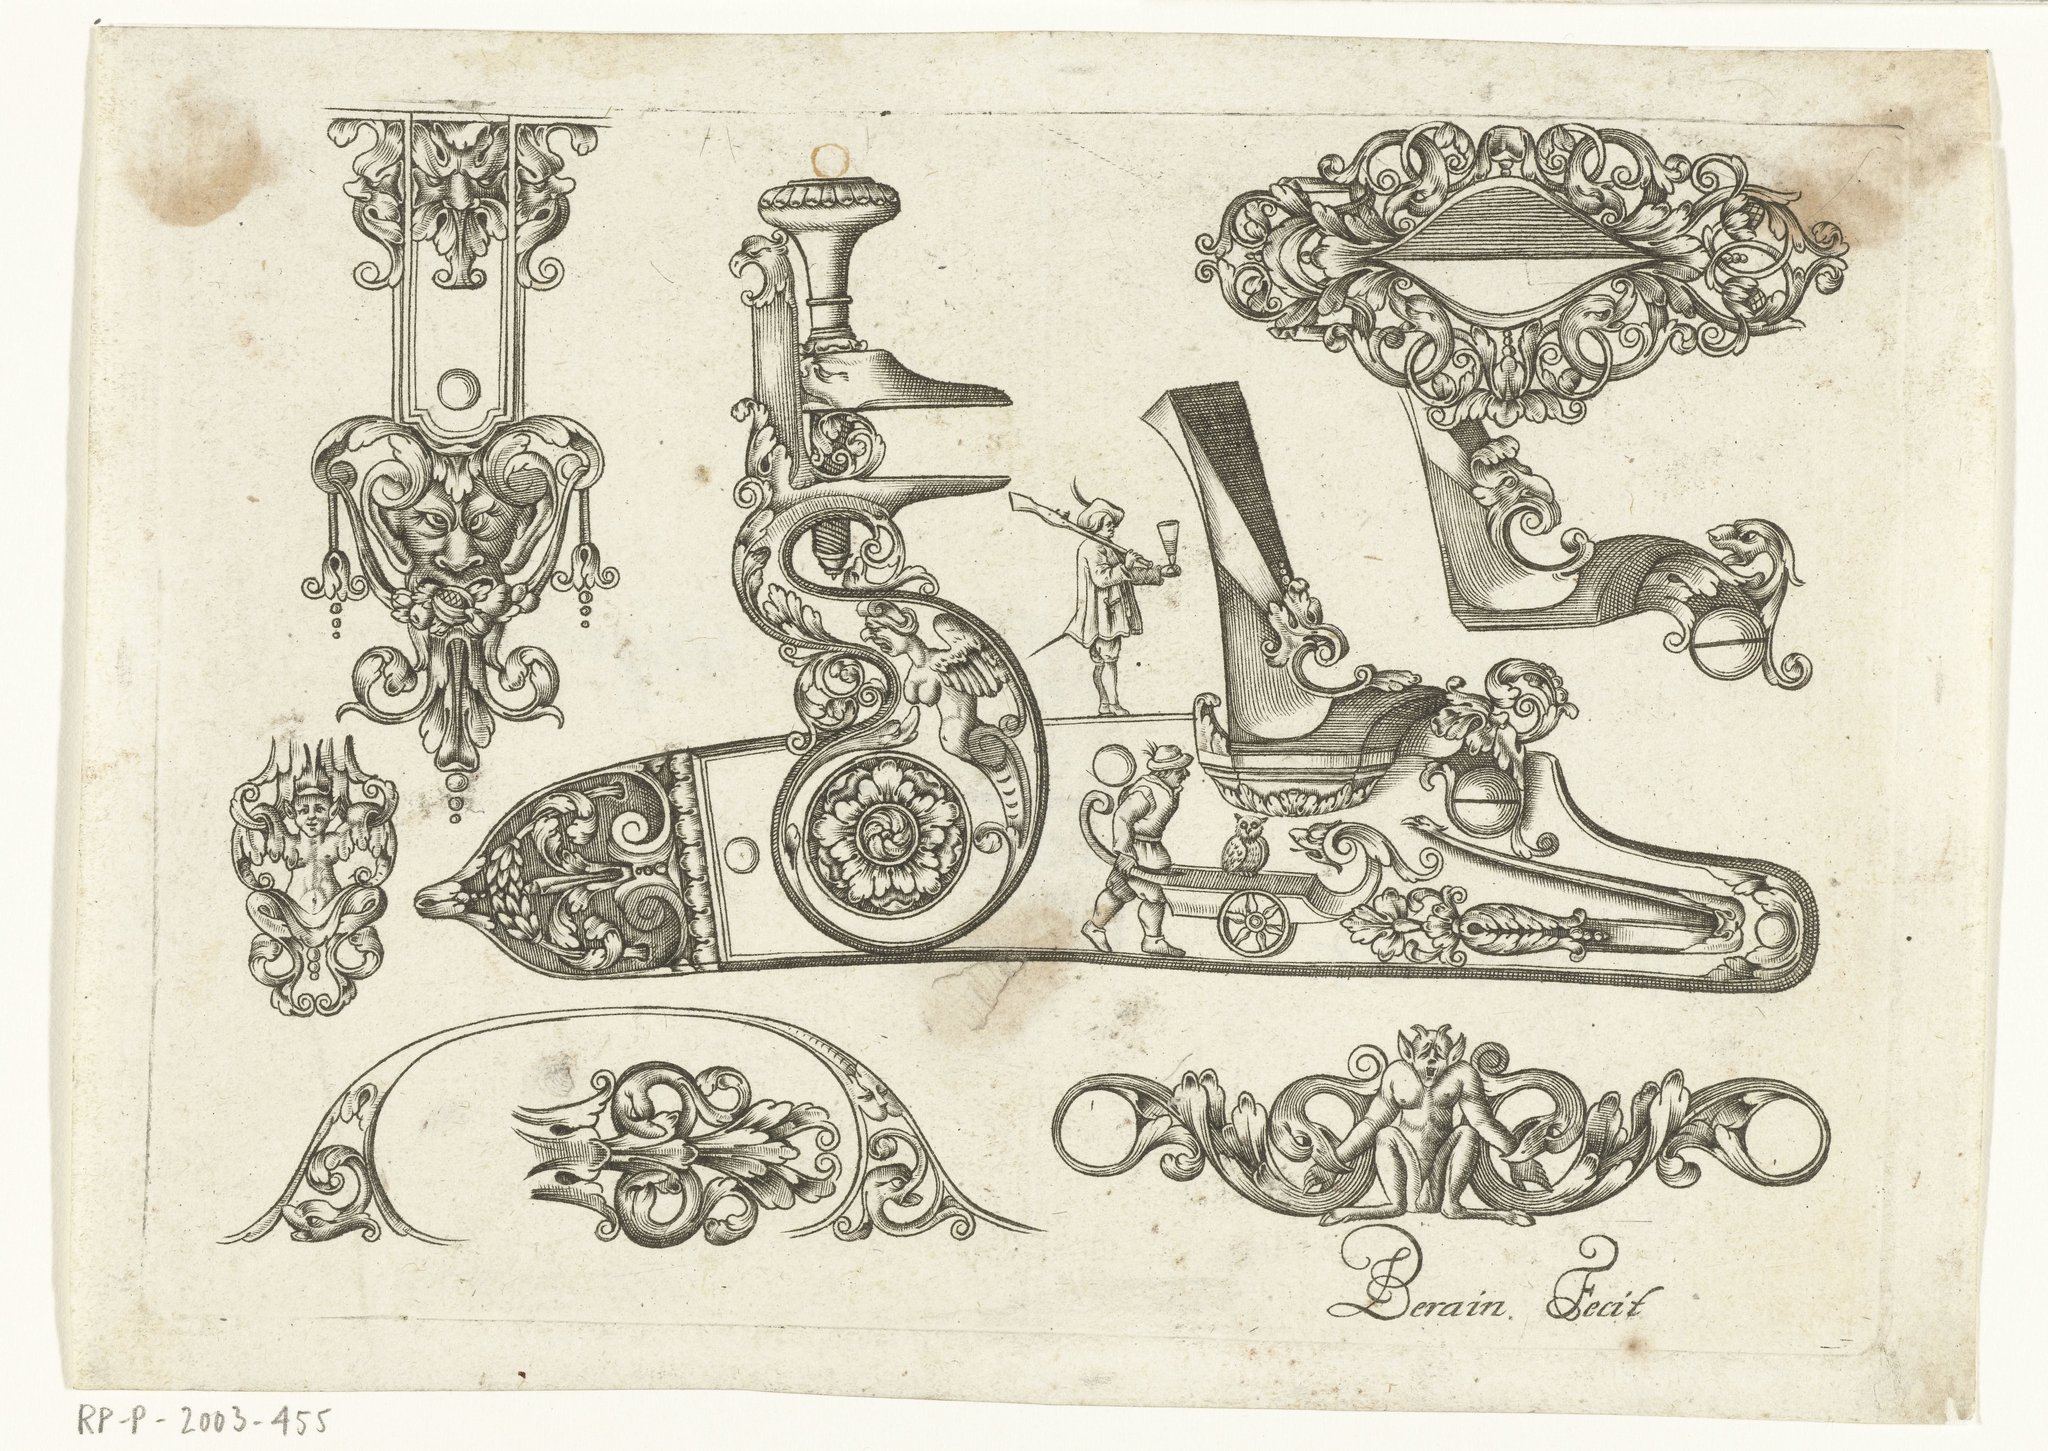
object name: ornament print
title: Ontwerpen voor onderdelen van musket of haakbus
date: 1659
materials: paper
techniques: engraving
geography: france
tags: ornaments ~ art, flat decoration ~ applied arts, firearms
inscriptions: signature: ‘Berain Fecit’